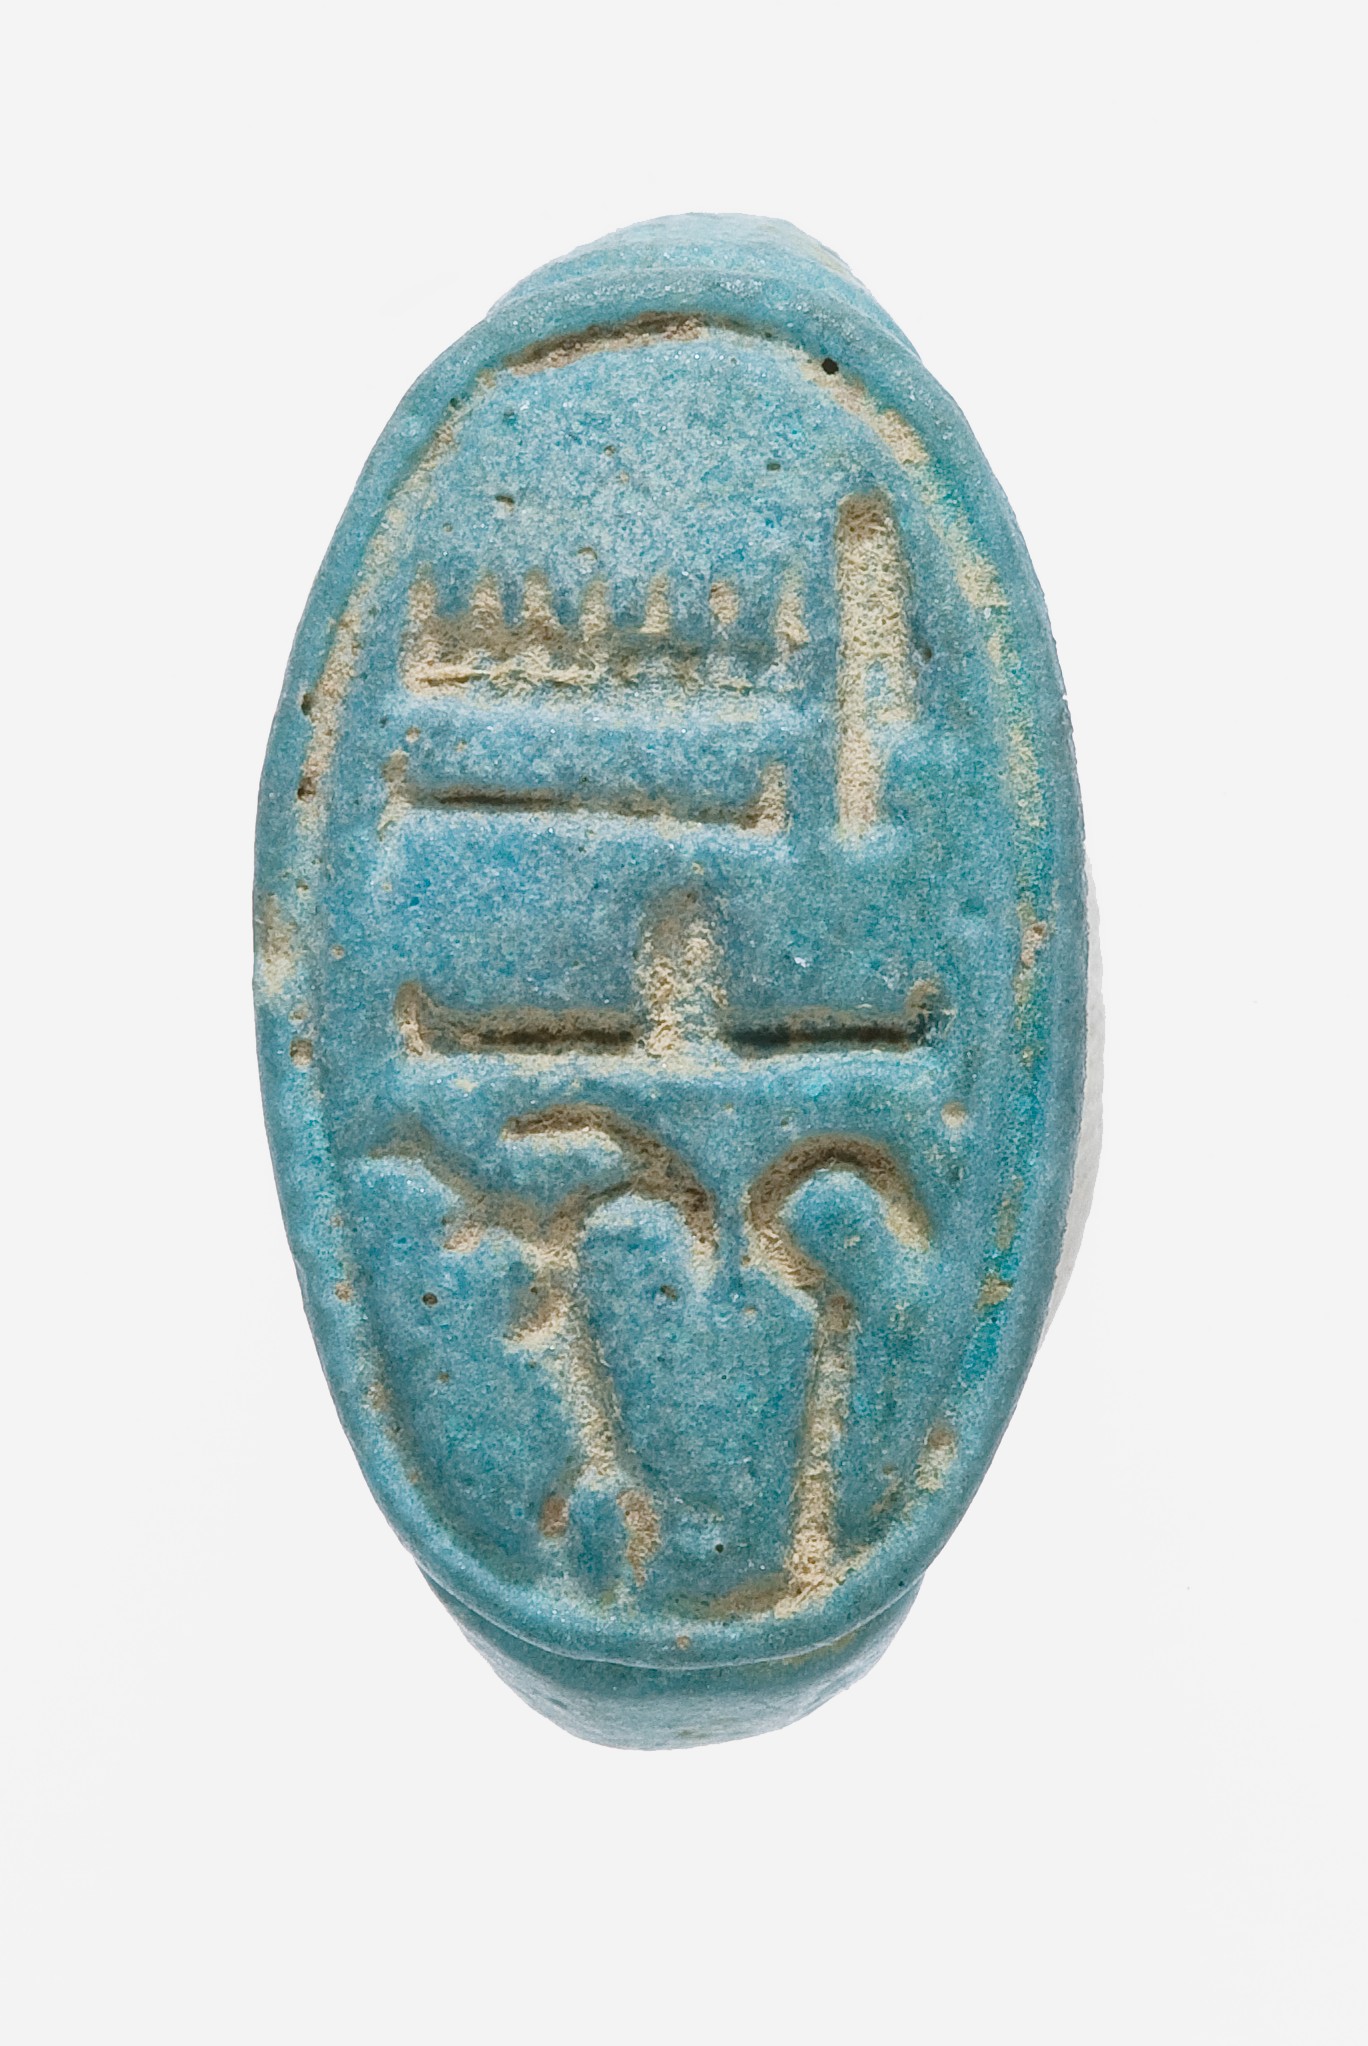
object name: ring, amenhotep iii, ruler of thebe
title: Ring Inscribed Amenhotep Ruler of Thebes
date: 1390-1352 BCE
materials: faience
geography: egypt